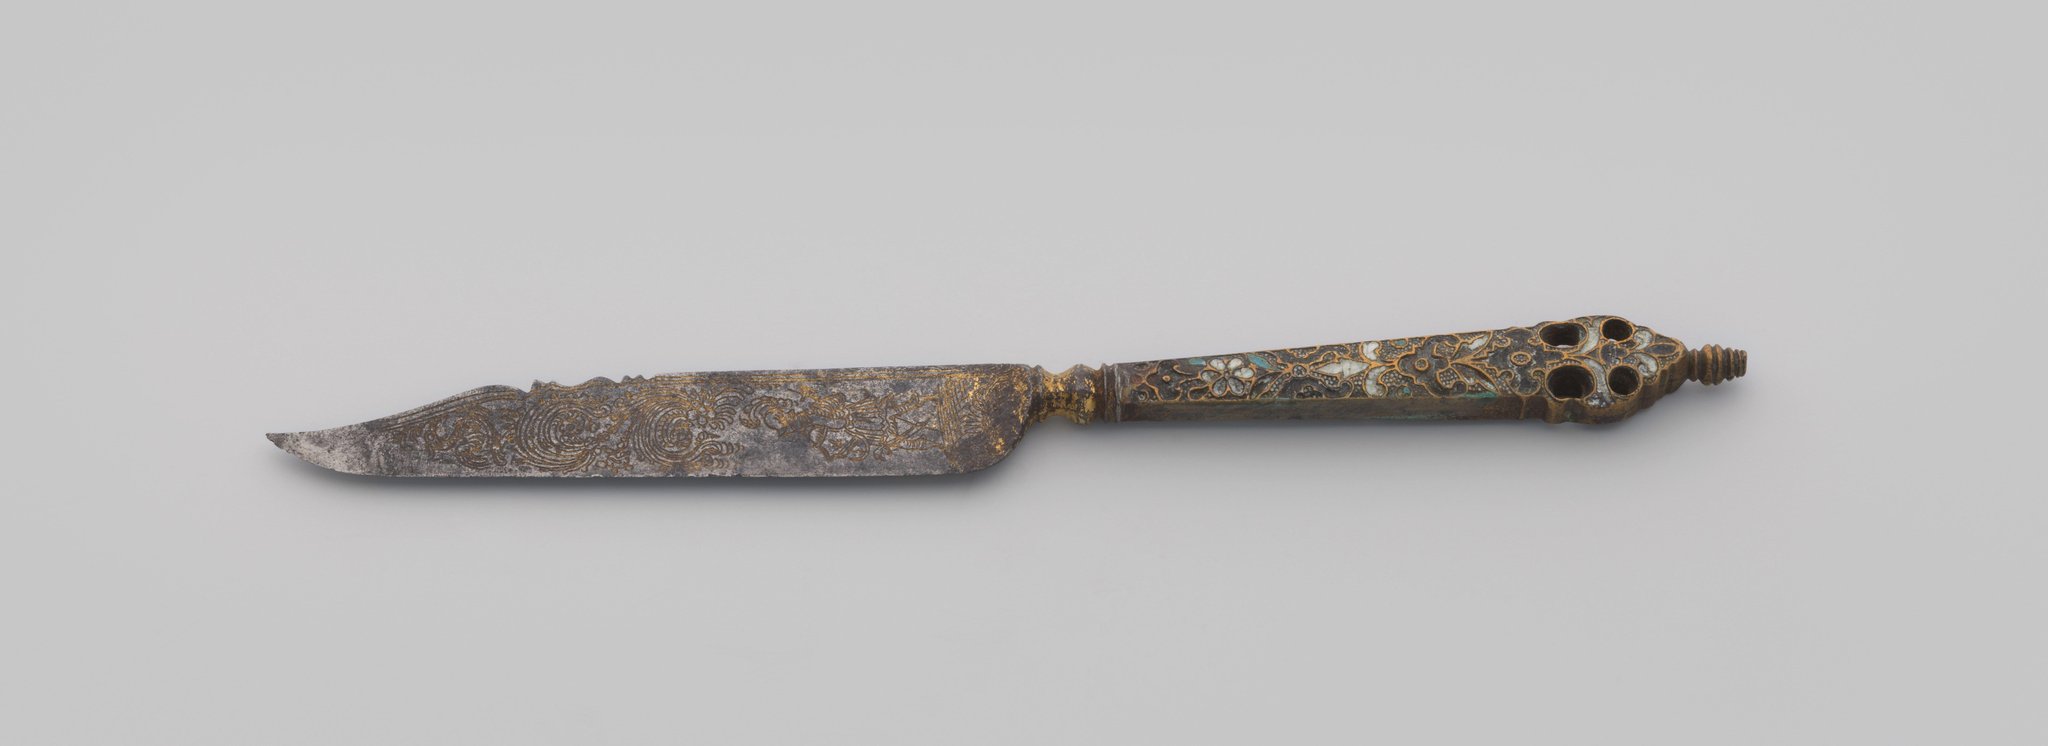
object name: knife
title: Mes met email versierd heft en gravures op lemmet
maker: Anonymous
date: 1575-1625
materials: copper, iron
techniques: enamel, engraving, gilding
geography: southern netherlands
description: Mes met ijzeren lemmet, dat versierd is met graveringen. Aan de ene zijde een springende hond, de andere zijde toont een soldaat met hellebaard en zwaard in de schede, daarboven gekrulde rankmotieven en op de top een vogel (fenix?). Het heft is versierd met bloemen van meerdere kleuren email. Het uiteinde van het heft is opengewerkt. Lemmet en heft zijn deels verguld.